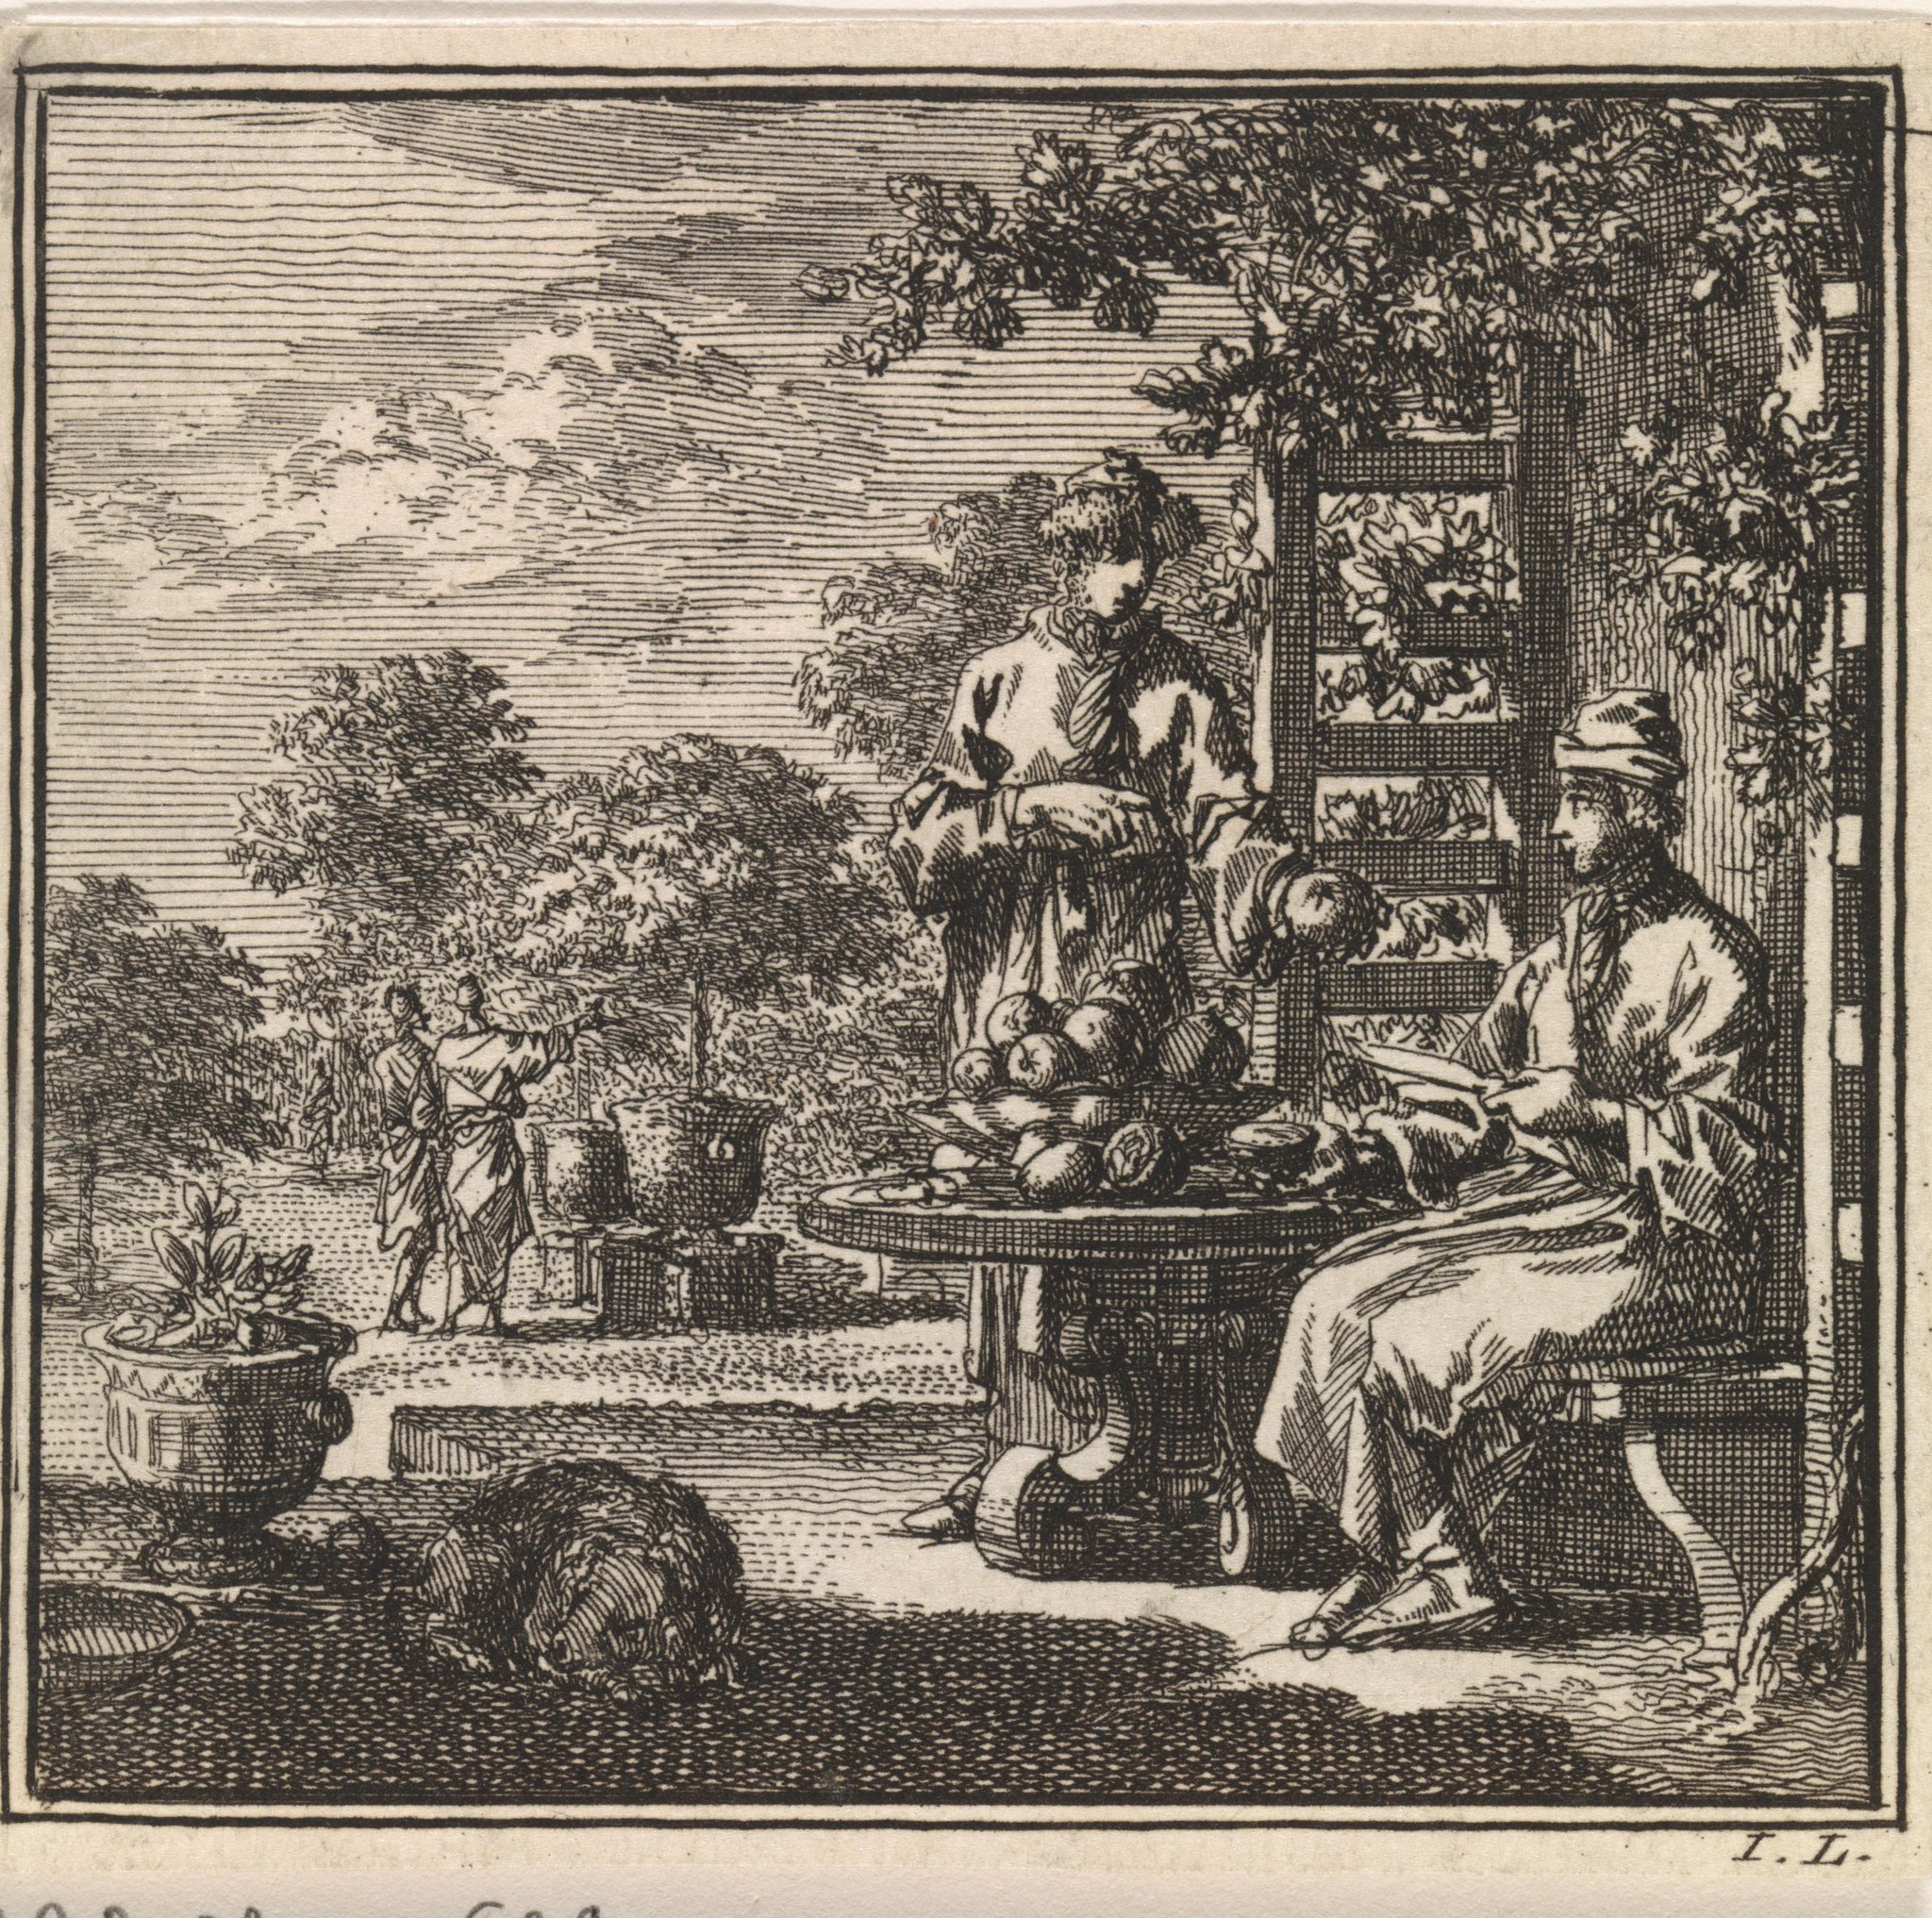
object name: book illustration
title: Gezicht op een tuin waar twee mannen sinaasappels bekijken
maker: jan luyken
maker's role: draughtsman, print maker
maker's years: 1649-1712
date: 1711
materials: paper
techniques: etching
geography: amsterdam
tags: garden, fruits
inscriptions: collector's mark: Lugt 2228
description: Illustratie voor: Luyken, Jan. De Bykorf des Gemoeds. Amsterdam: Pieter Arentsz. II (wed.) en Cornelis van der Sys, 1711, p. 370.